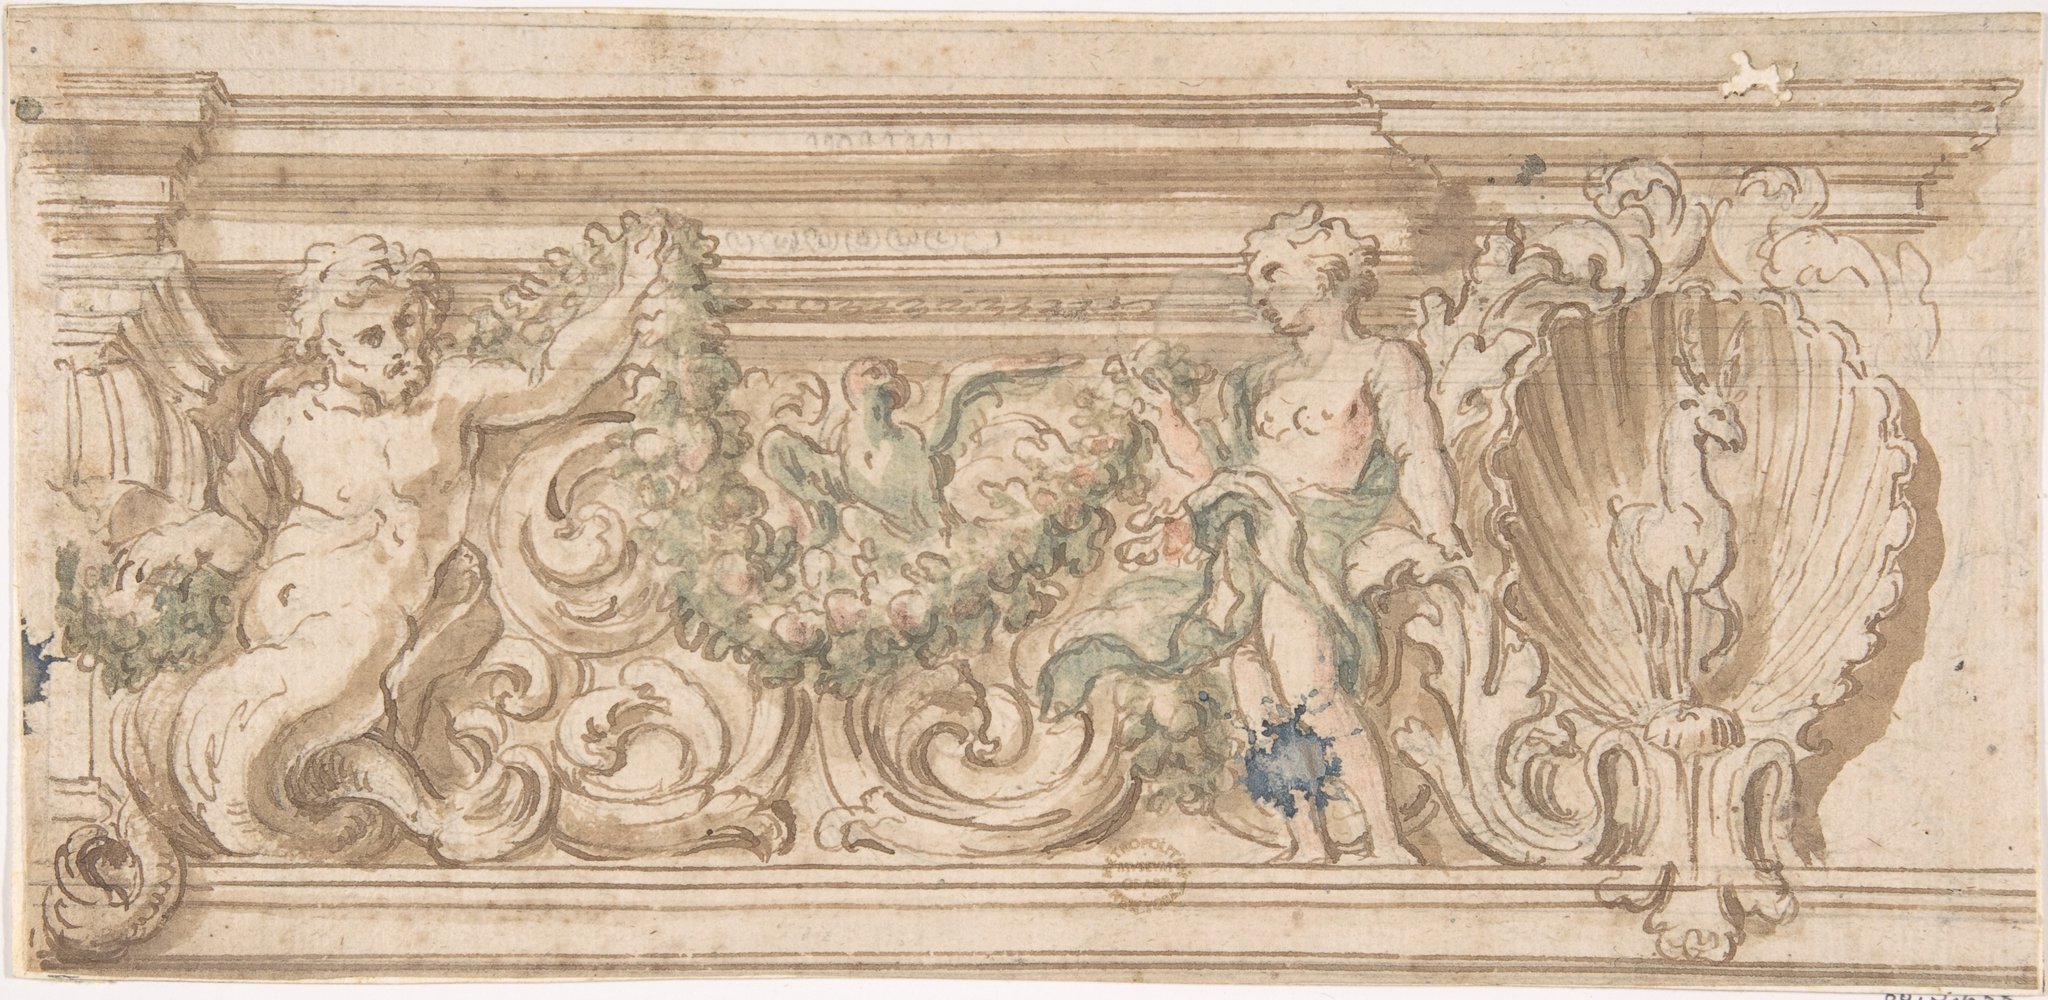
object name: drawing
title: Ceiling Decoration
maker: anonymous, italian, 17th century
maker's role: artist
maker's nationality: italian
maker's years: 1600-1700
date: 1601-1700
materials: ink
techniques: brush, pen, wash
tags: animals,birds,men,women